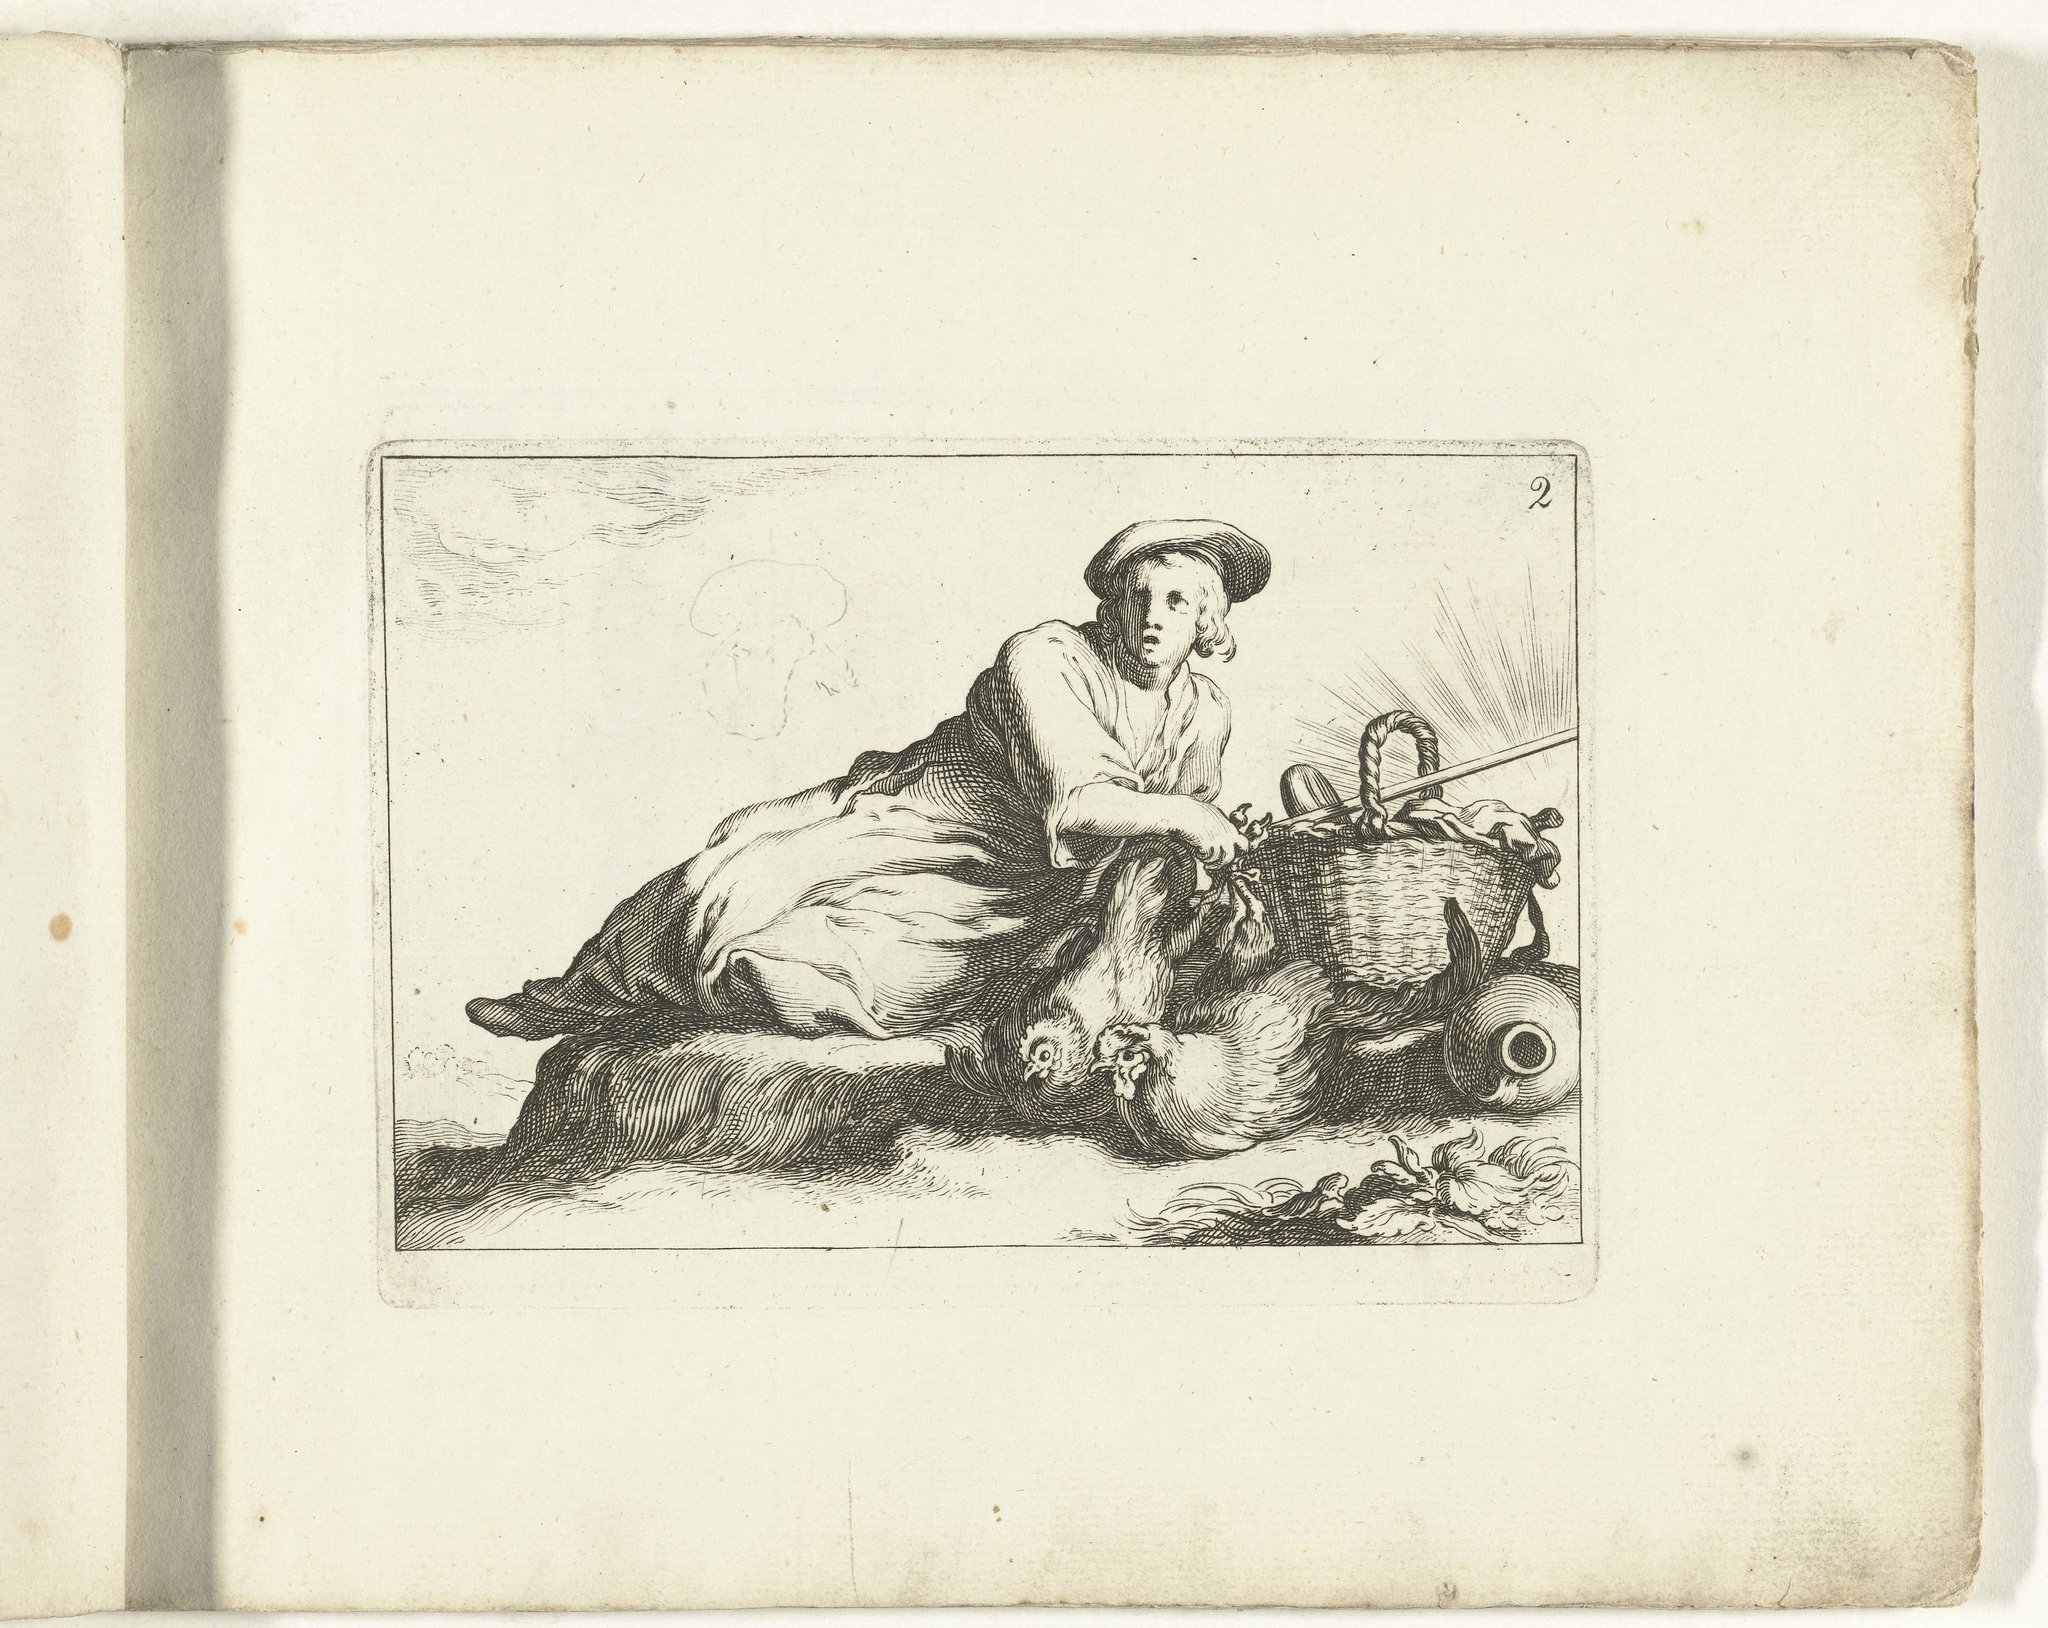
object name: print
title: Liggende vrouw met kippen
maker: cornelis bloemaert (ii)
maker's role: draughtsman, print maker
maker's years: 1603-1692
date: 1700-1800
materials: paper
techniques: engraving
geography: utrecht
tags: pastorals, arcadian scenes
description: Een vrouw ligt te rusten met een mand en twee kippen naast haar.